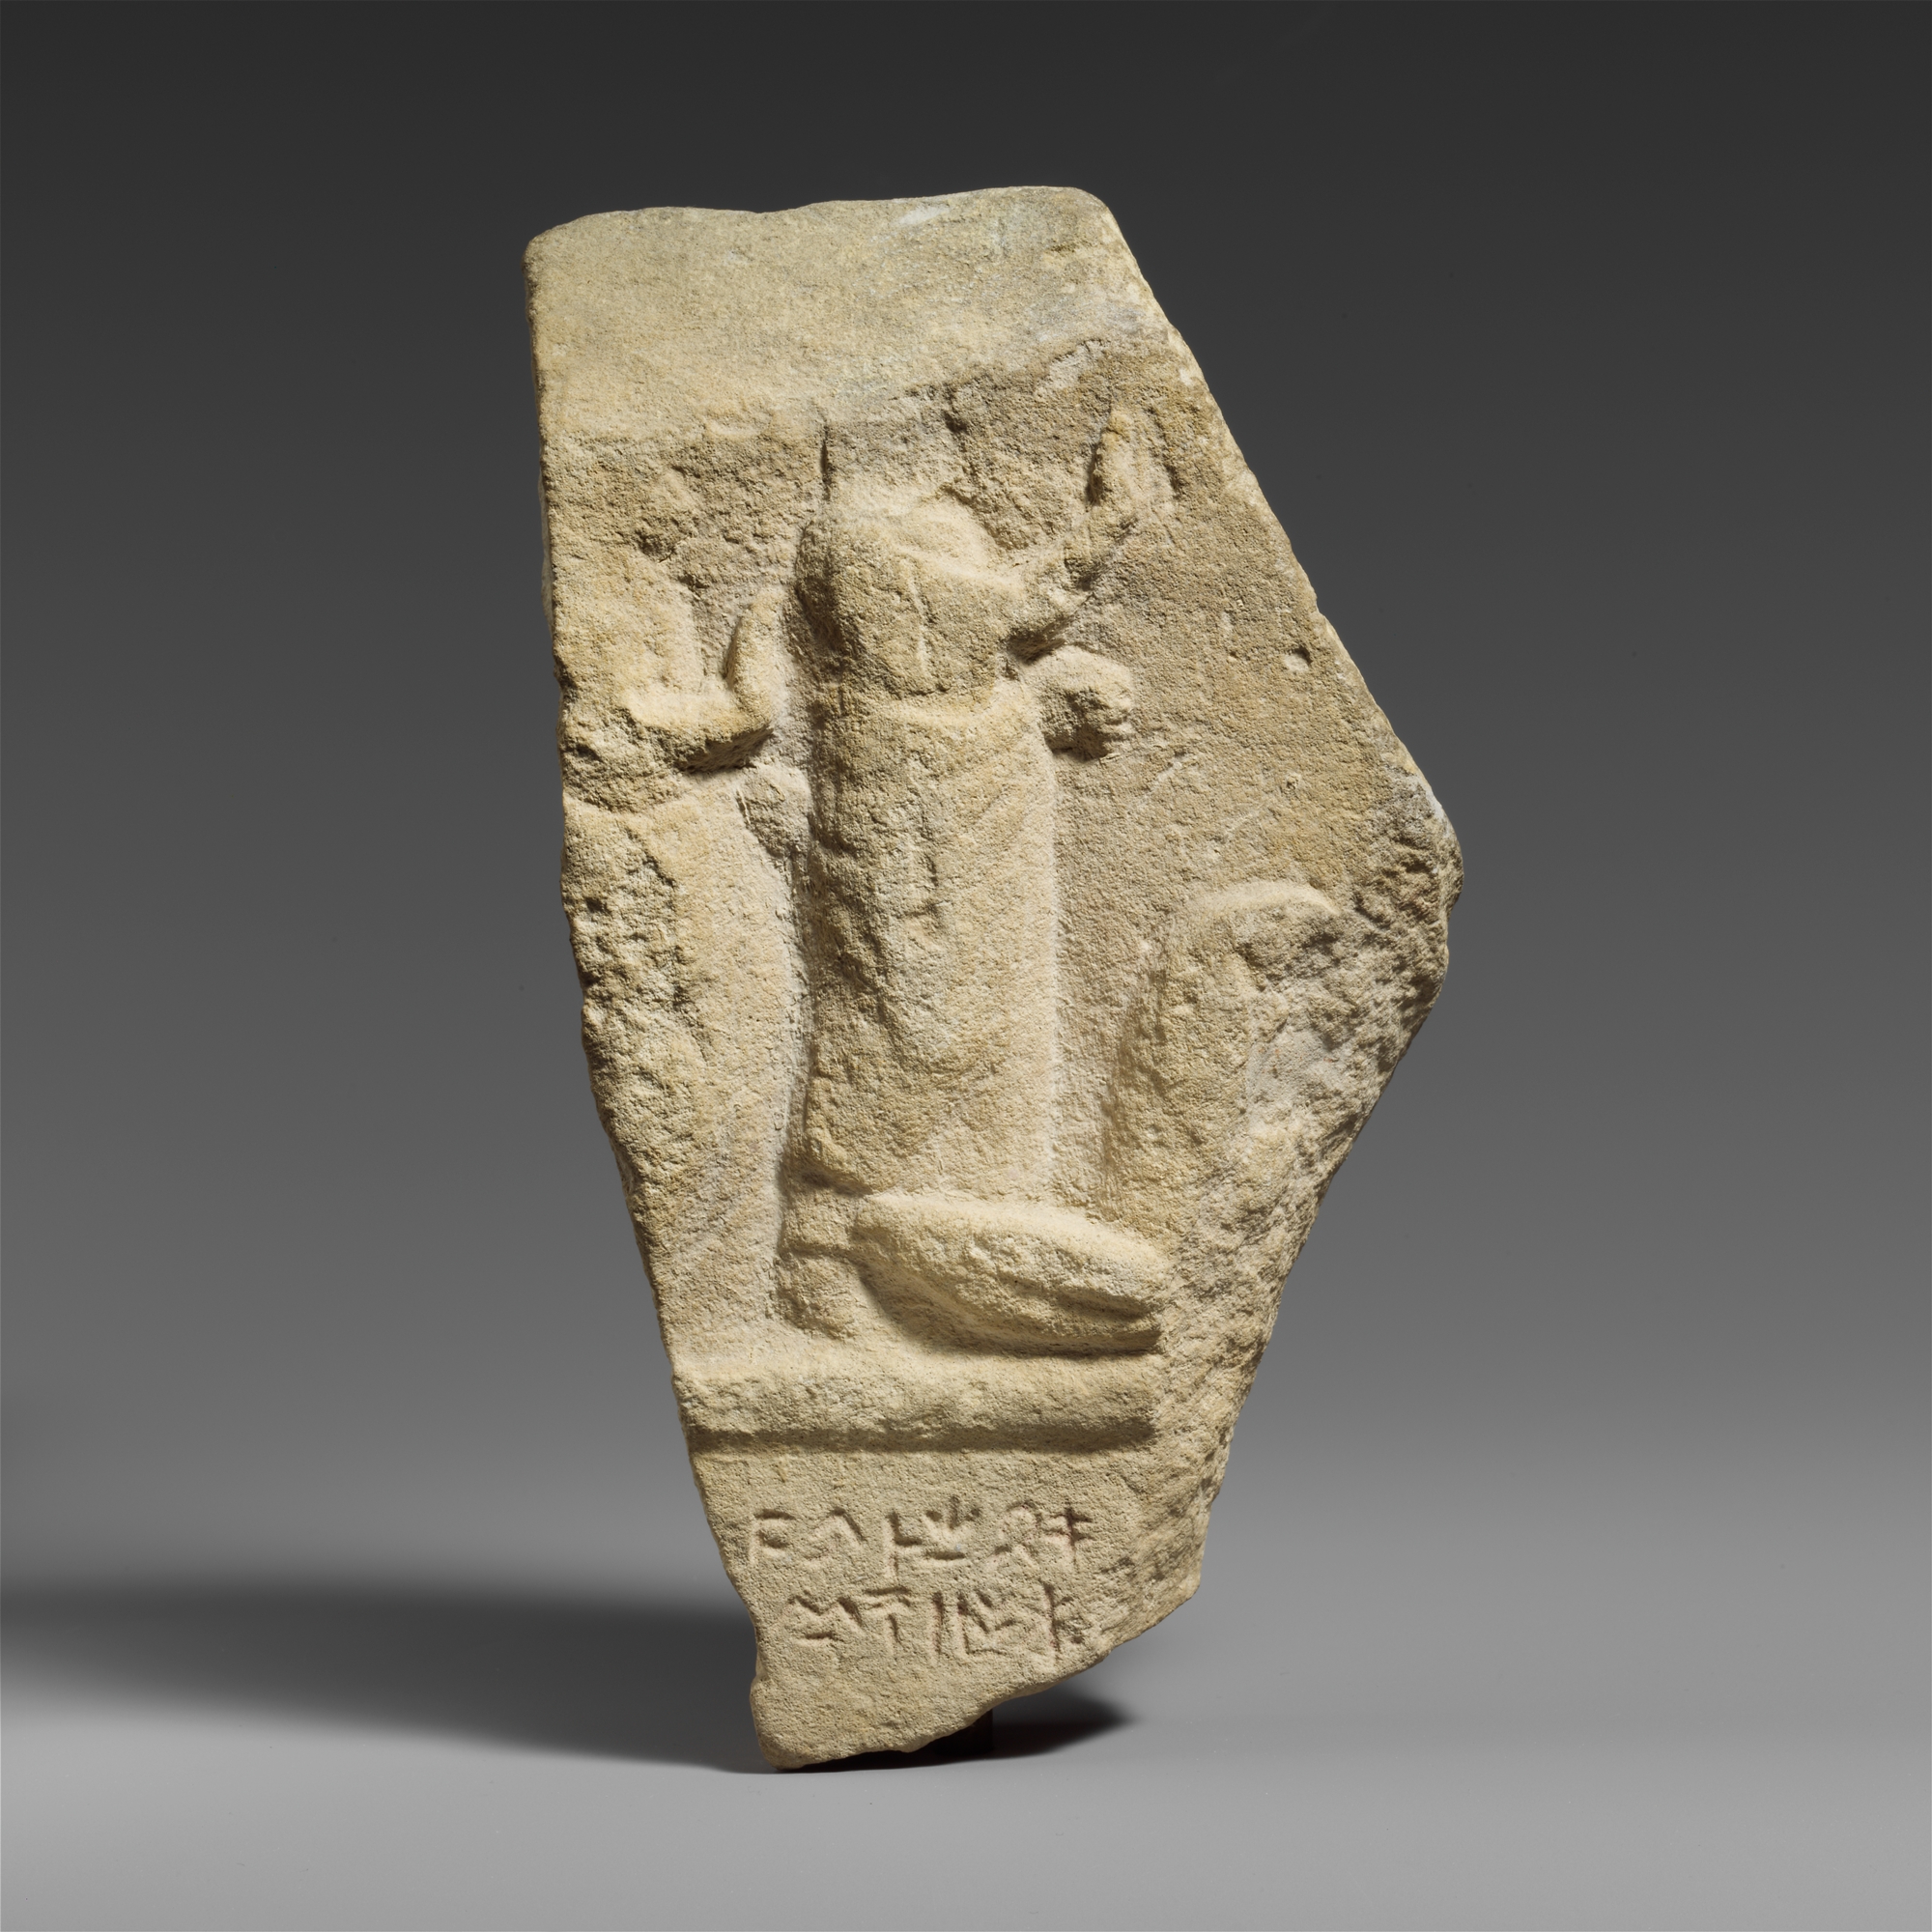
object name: relief of two votary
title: Fragment of a limestone votive relief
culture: cypriot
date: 330 BCE-4 CE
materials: limestone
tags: human figures